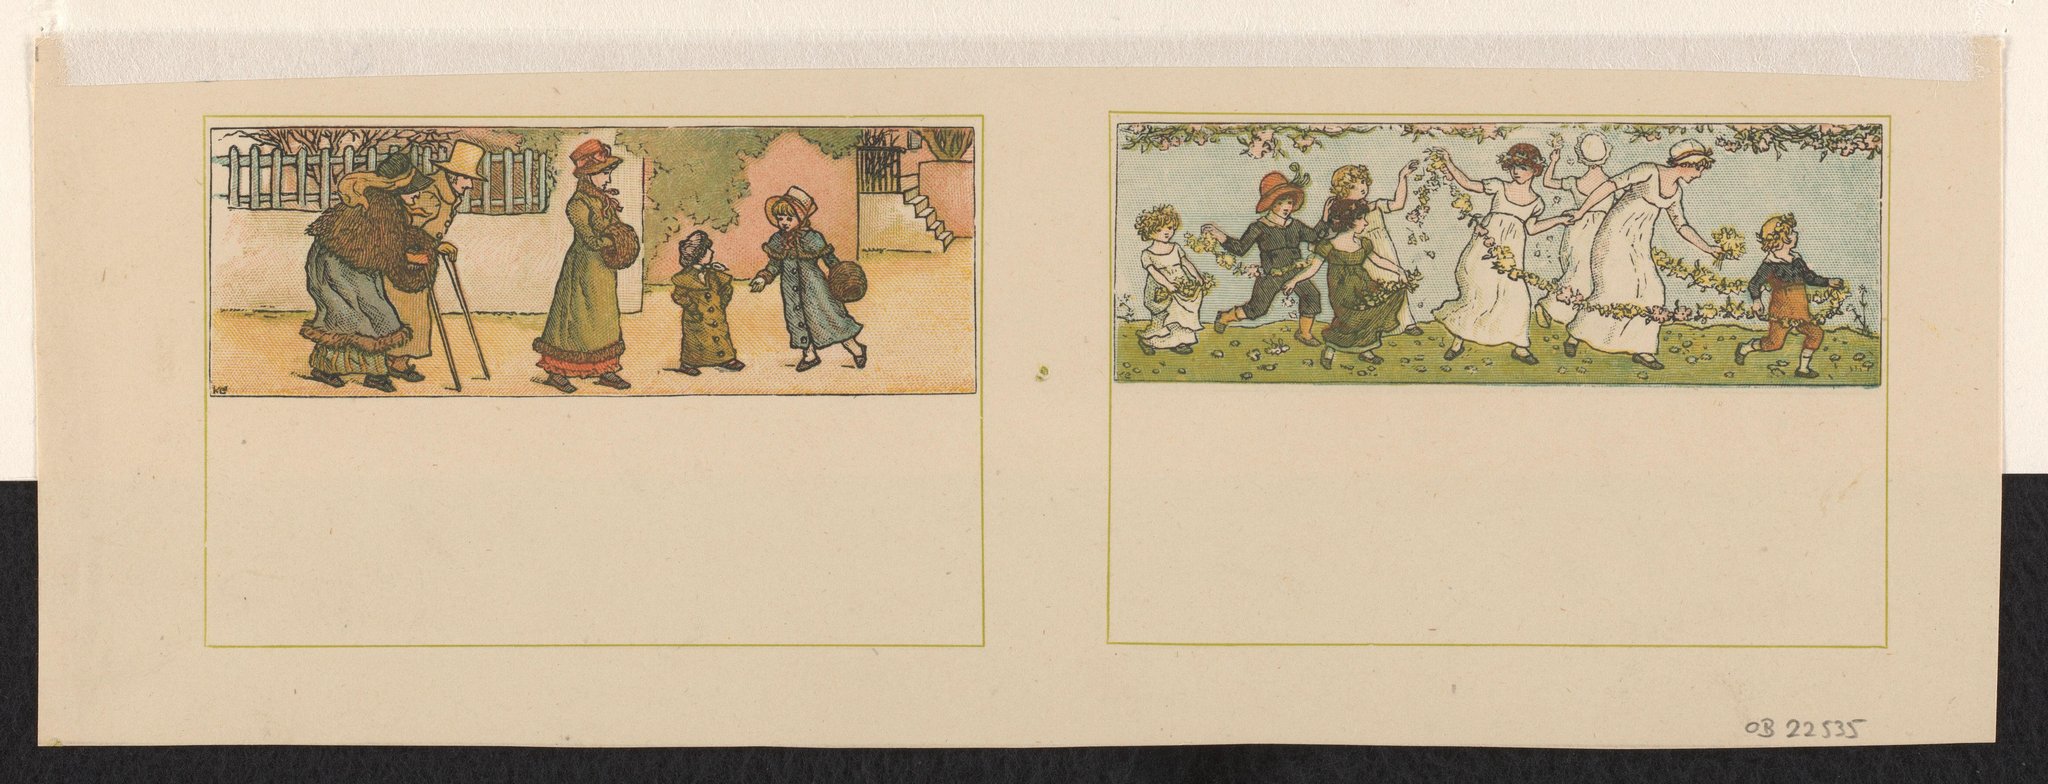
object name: print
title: Familie op straat en dansende figuren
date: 1856-1901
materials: paper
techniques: wood engraving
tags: dancing, family, descendance, street (+ city(-scape) with figures, staffage)